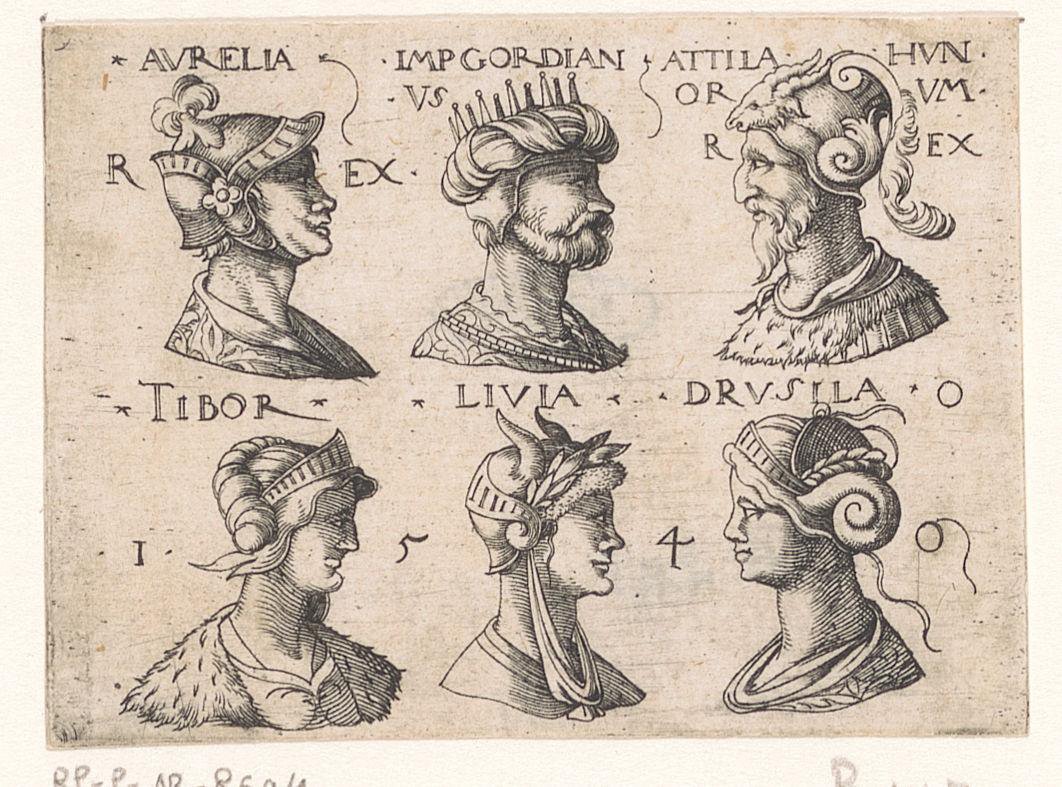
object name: print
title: Bustes van historische figuren uit de oudheid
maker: virgilius solis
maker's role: draughtsman, print maker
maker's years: 1514-1562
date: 1540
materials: paper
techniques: engraving, etching, intaglio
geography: nuremberg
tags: chest, bust, head-gear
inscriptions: number: ‘12’, collector's mark: Lugt 2228